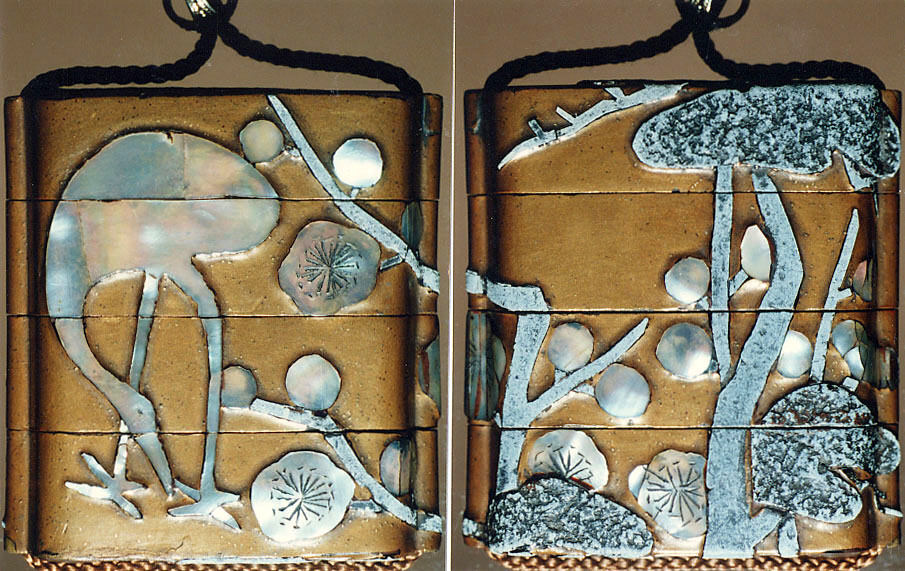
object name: inrō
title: Inrō with Crane and Plum Tree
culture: japanese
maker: ogata kōrin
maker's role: artist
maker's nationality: japanese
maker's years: 1658-1716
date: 1801-1900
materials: gold, lacquer, metal, mother of pearl, pewter, wood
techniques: carving, inlay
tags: cranes,trees